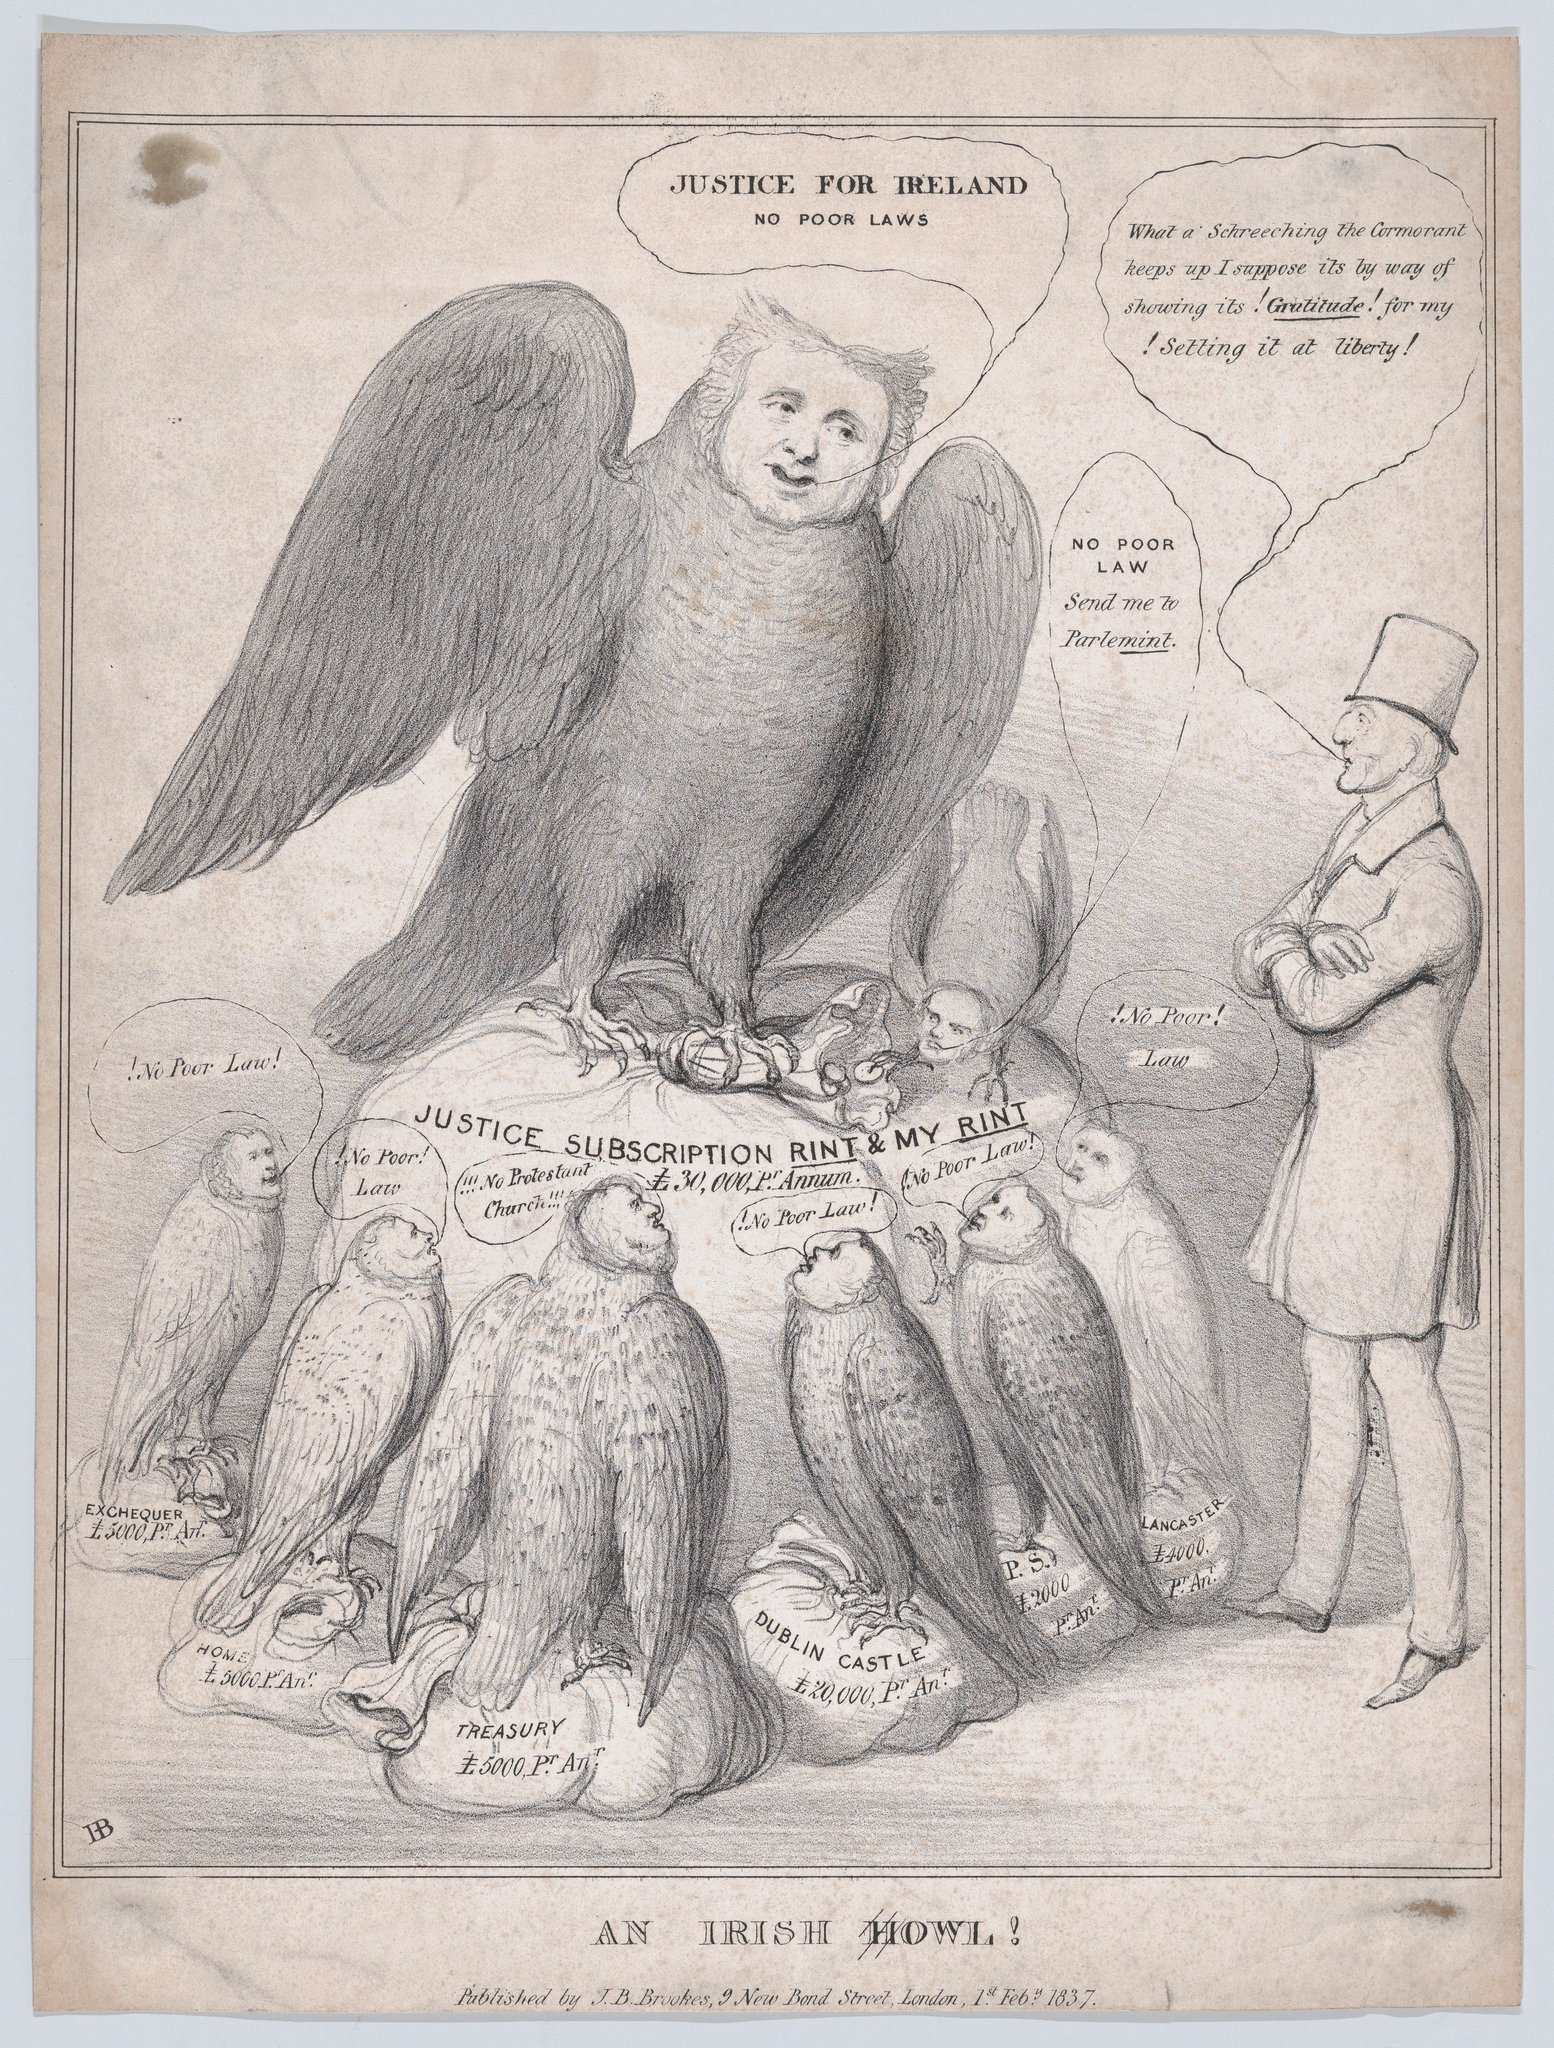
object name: print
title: An Irish Howl [Owl]!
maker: john doyle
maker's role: artist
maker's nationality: irish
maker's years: 1797-1868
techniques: lithograph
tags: satire,men,owls